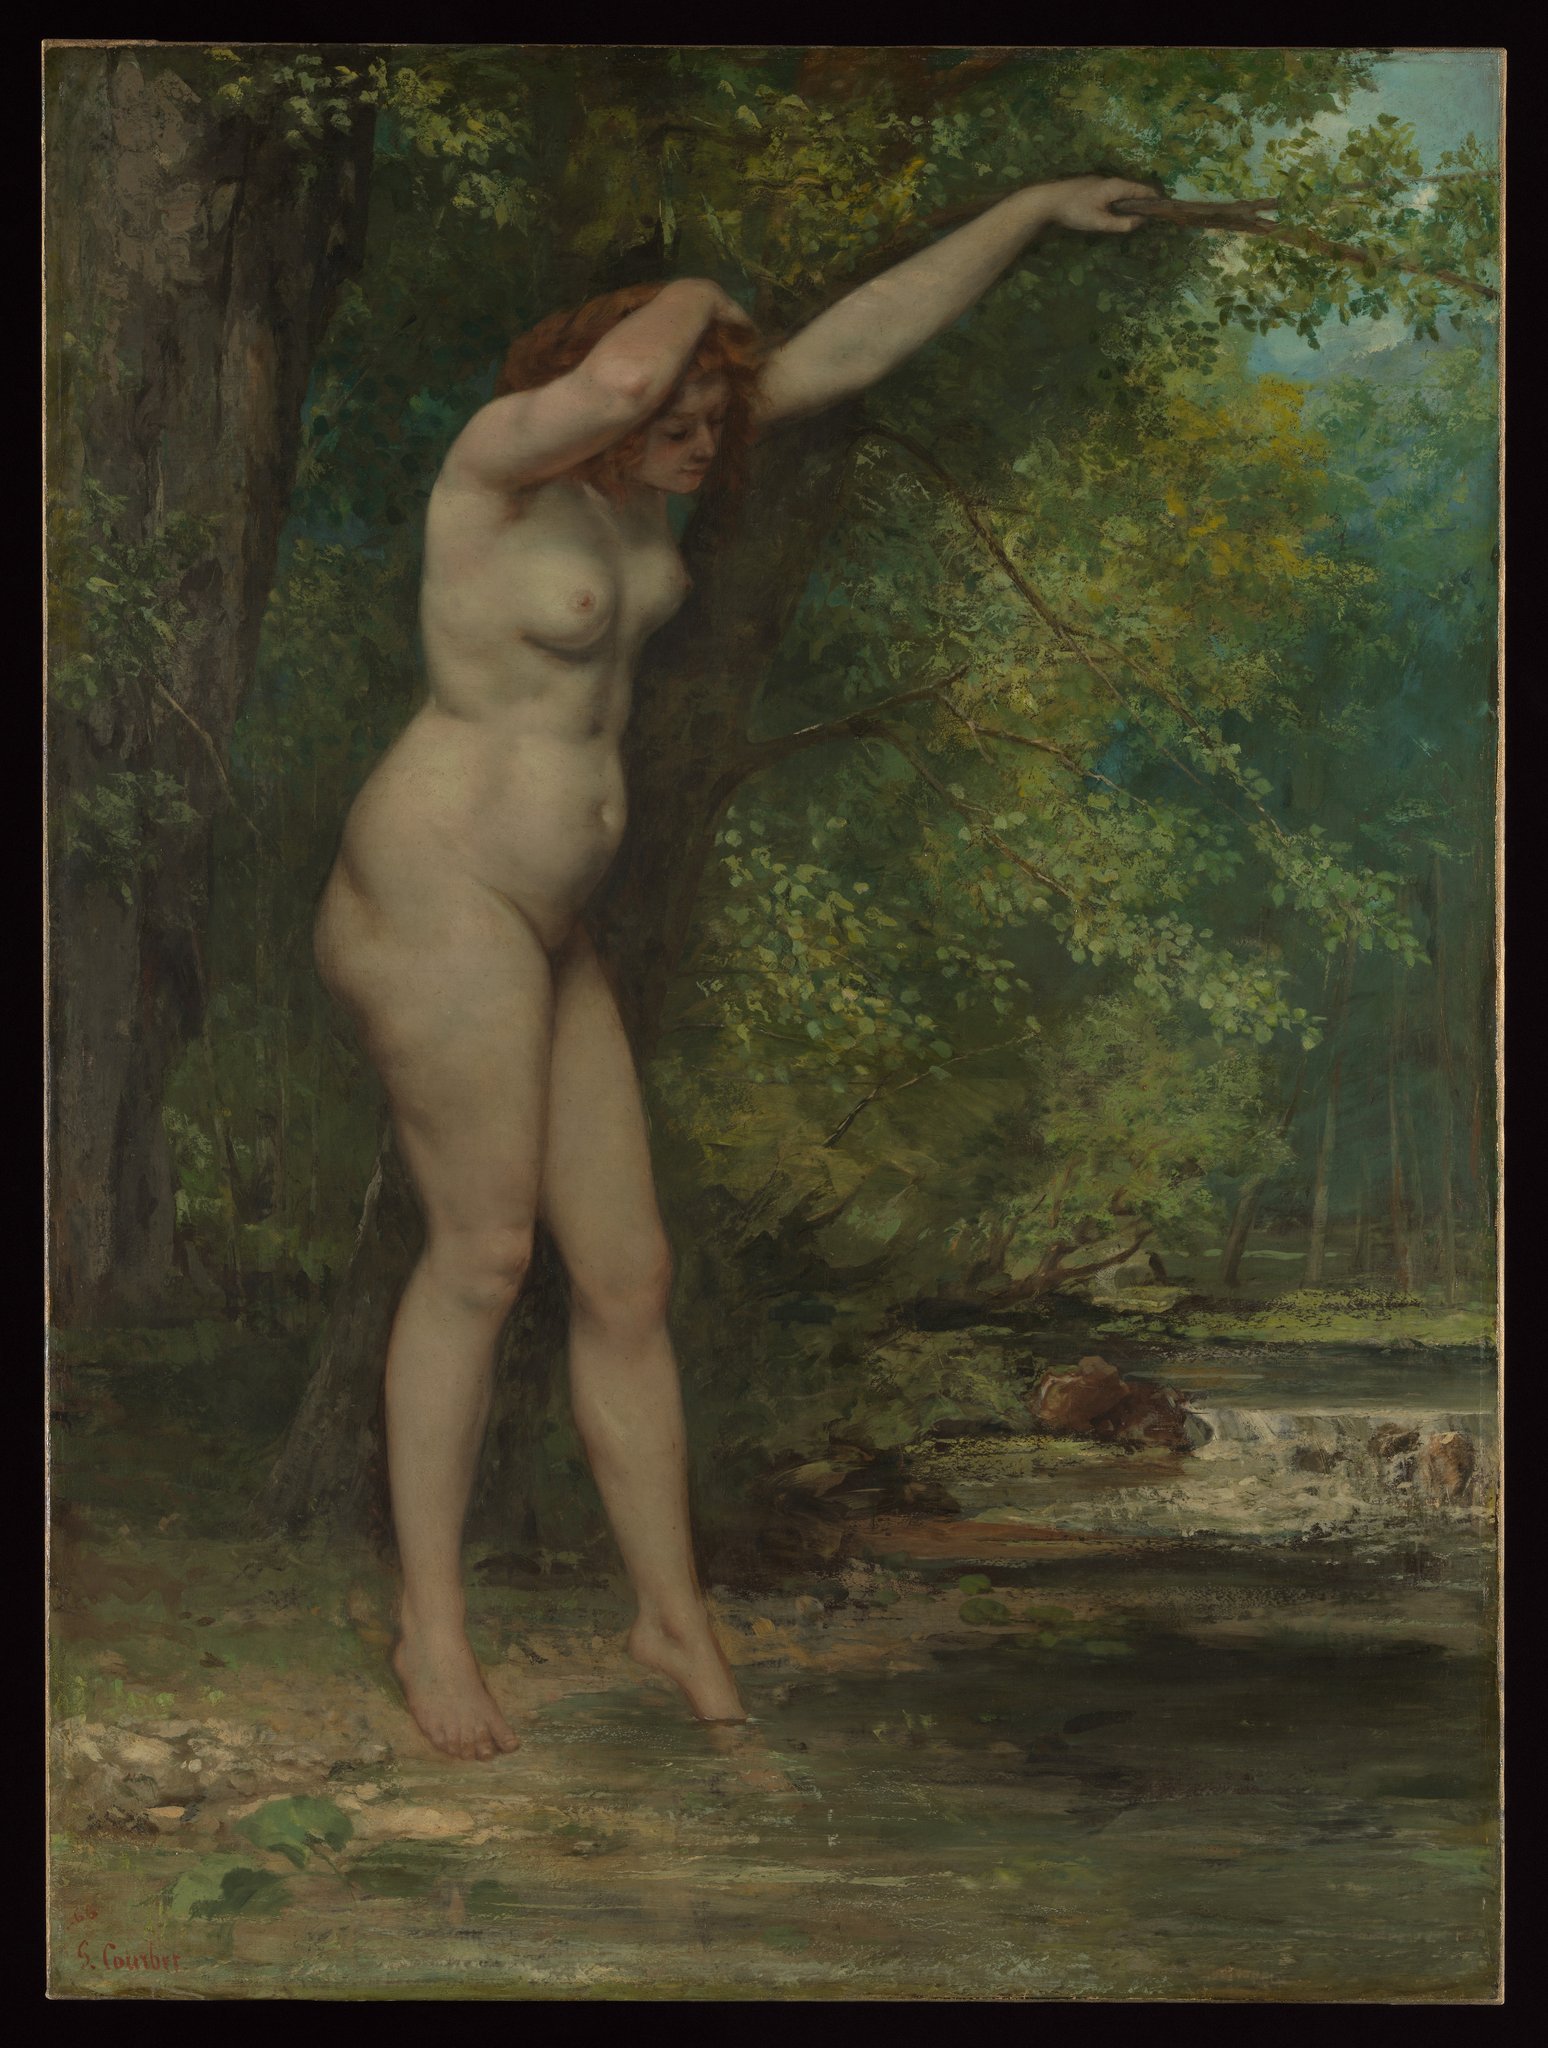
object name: painting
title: The Young Bather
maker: gustave courbet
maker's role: artist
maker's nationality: french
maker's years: 1819-1877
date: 1866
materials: canvas, oil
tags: female nudes,bathing